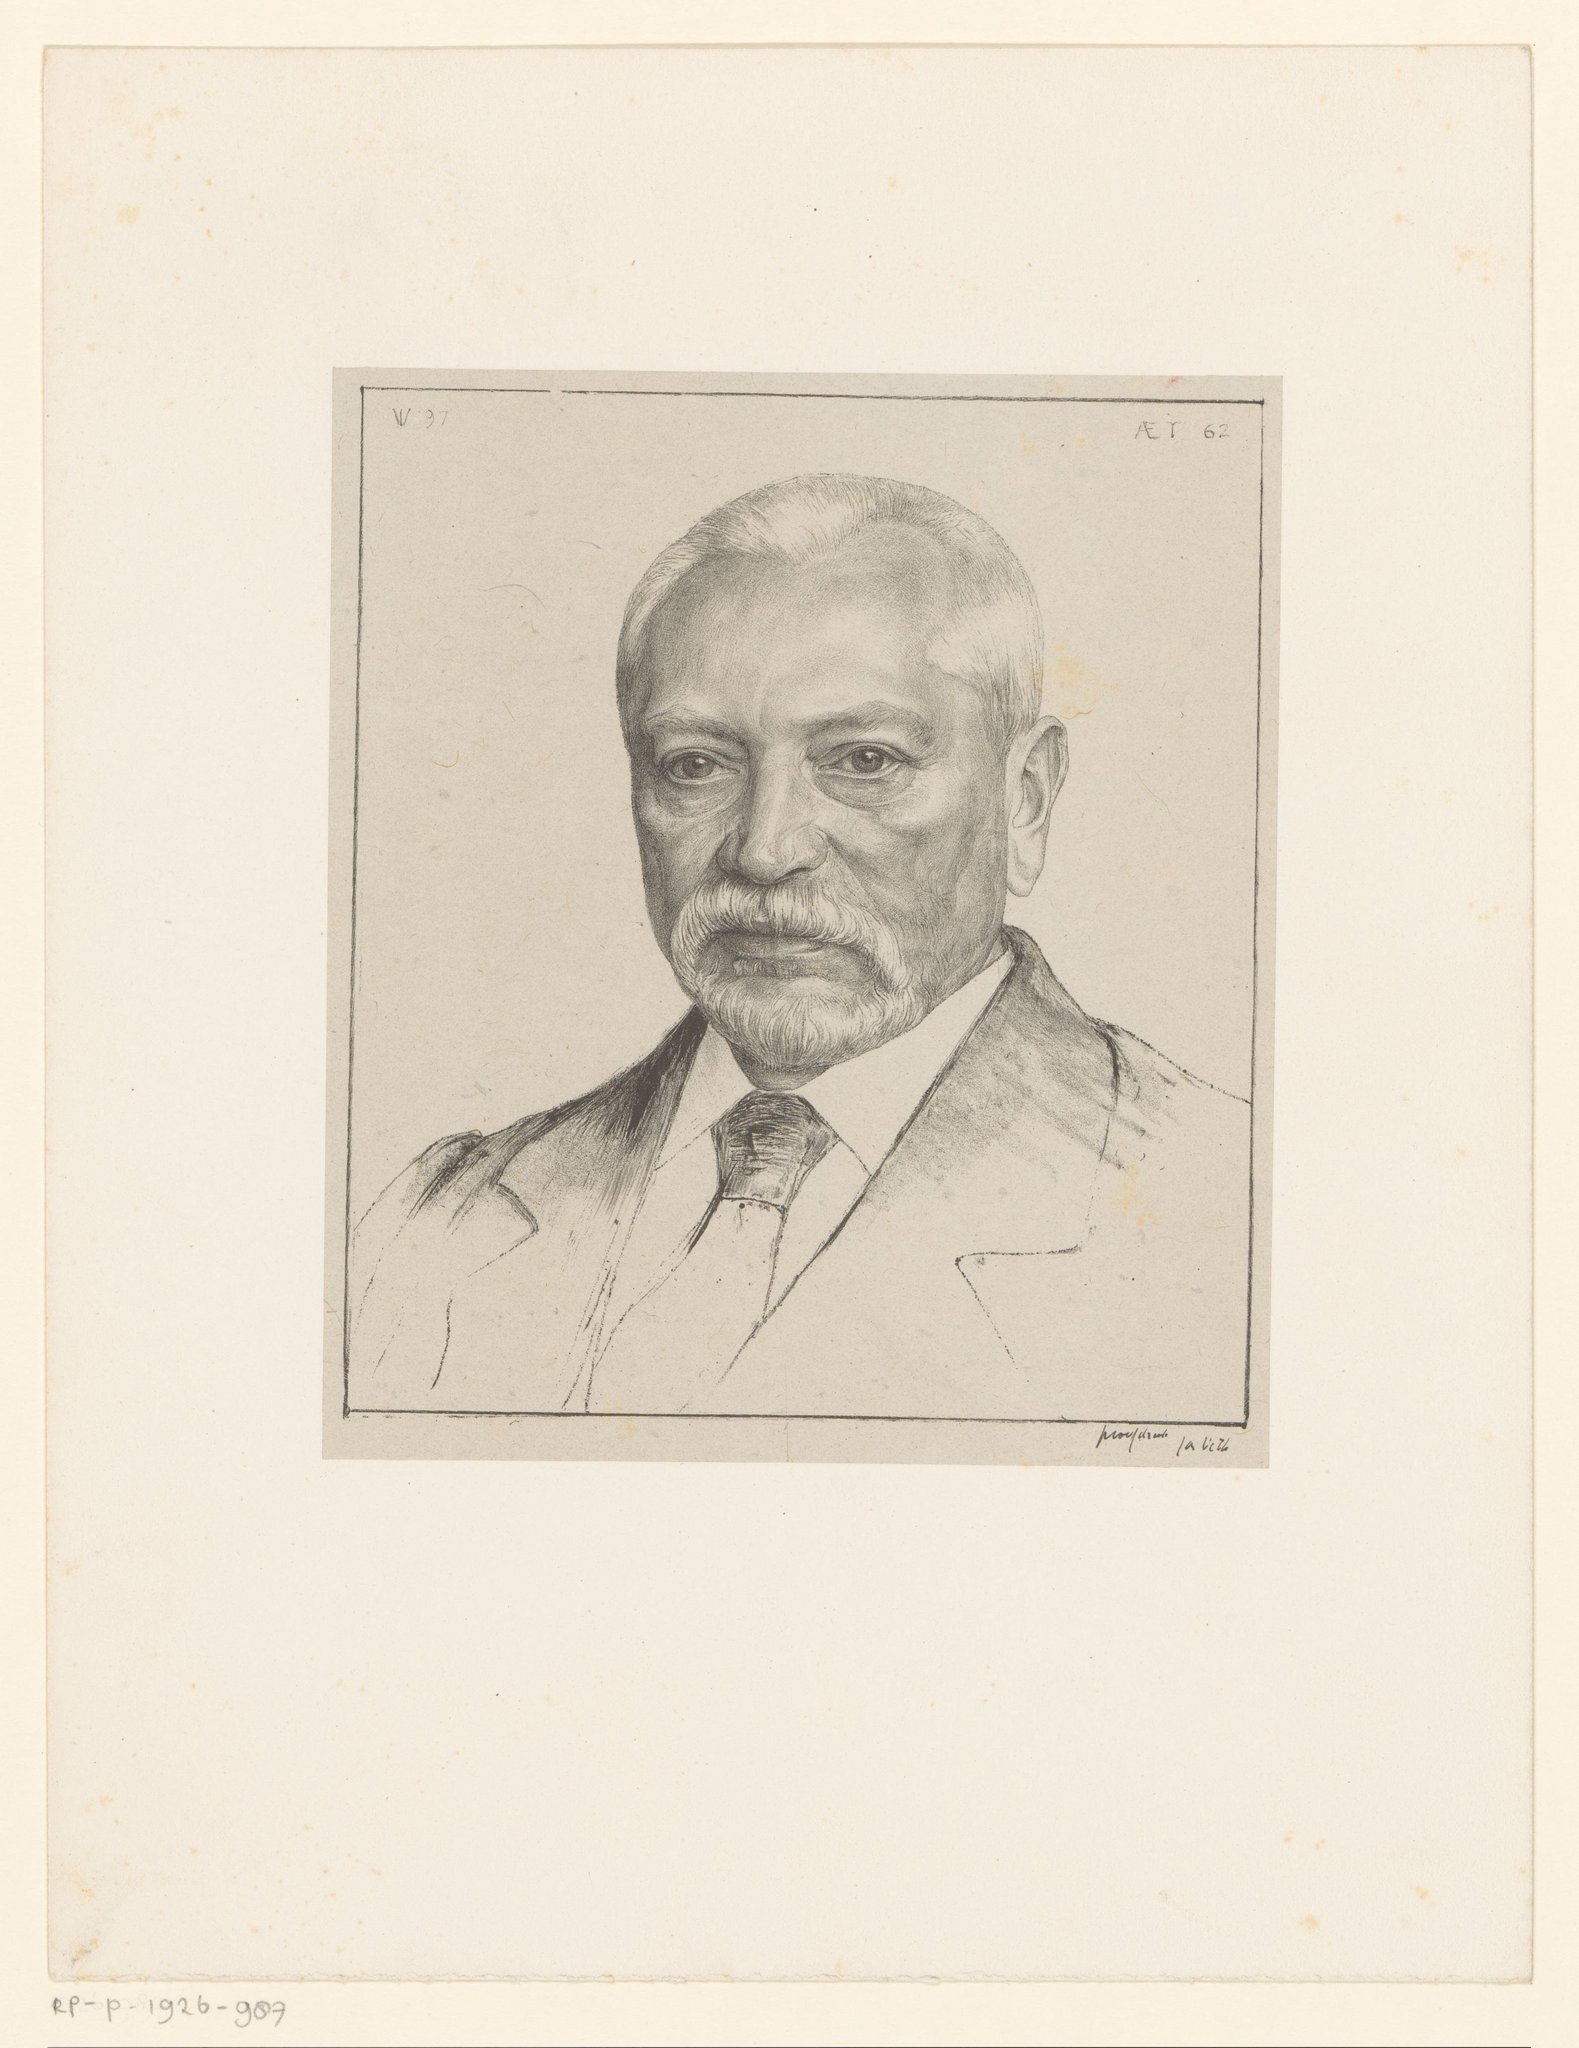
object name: print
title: Portret van Theodorus Hendrik Mac Gillavry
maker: jan veth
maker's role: designer, draughtsman, painter, print maker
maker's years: 1864-1925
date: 1897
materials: paper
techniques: lithograph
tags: historical persons (+ (full) bust portrait)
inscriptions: collector's mark: Lugt 2228, inscription: ‘Proefdruk / Jan Veth’